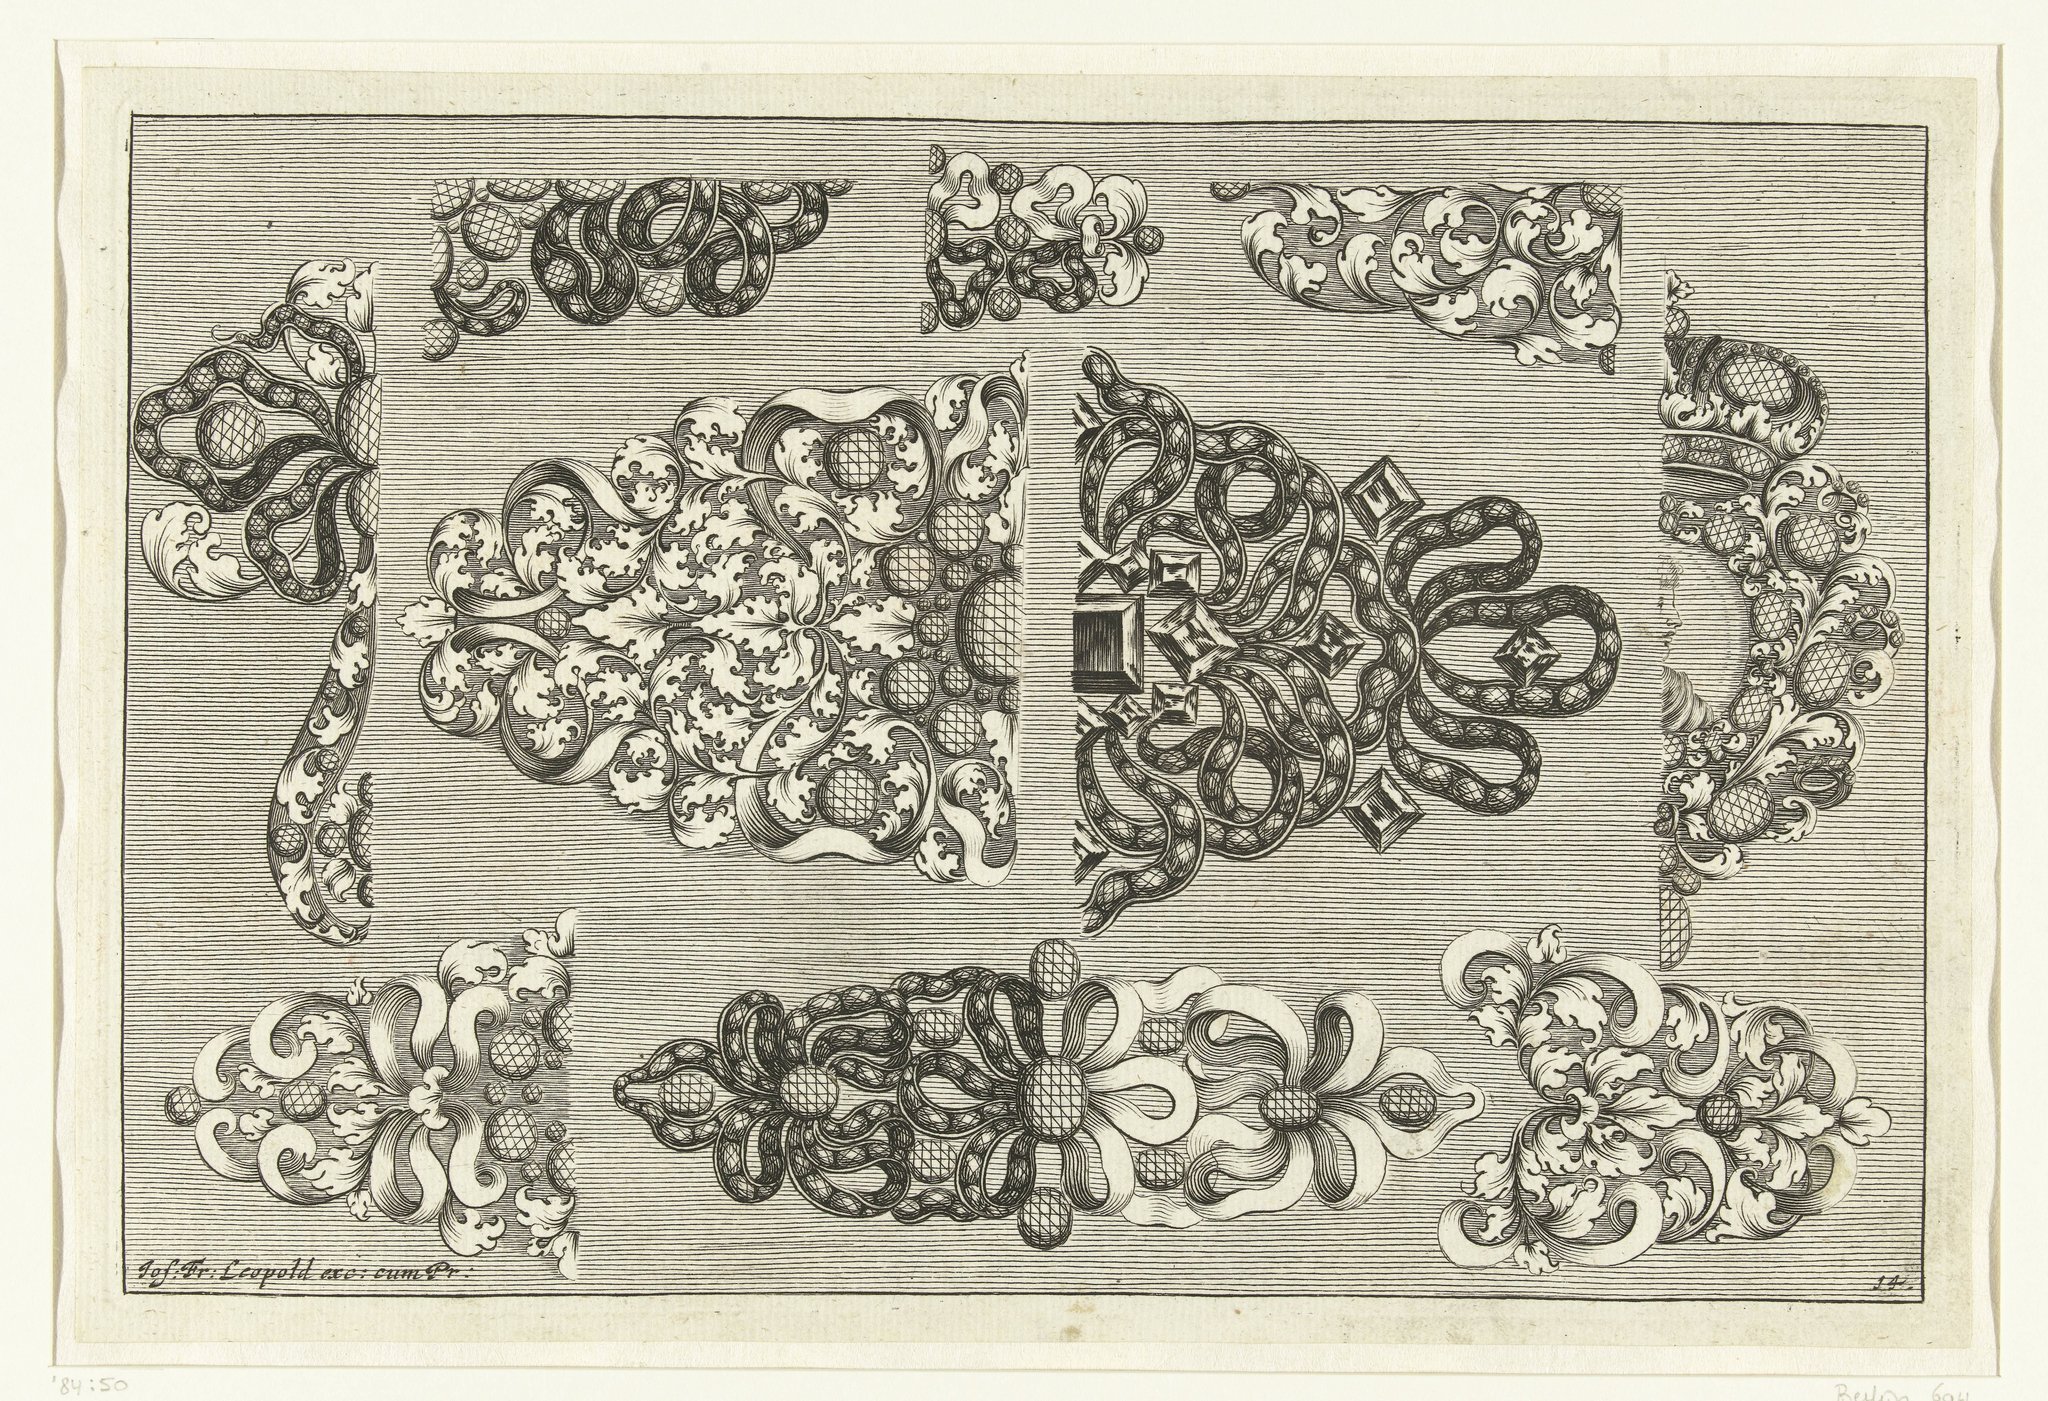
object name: ornament print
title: Tien ontwerpen voor juwelen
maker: joseph friedrich leopold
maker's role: print maker, publisher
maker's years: 1668-1726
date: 1695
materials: paper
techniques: engraving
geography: augsburg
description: Negen ontwerpen zijn slechts voor de helft weergegeven. Blad 14 uit serie van 17 bladen.